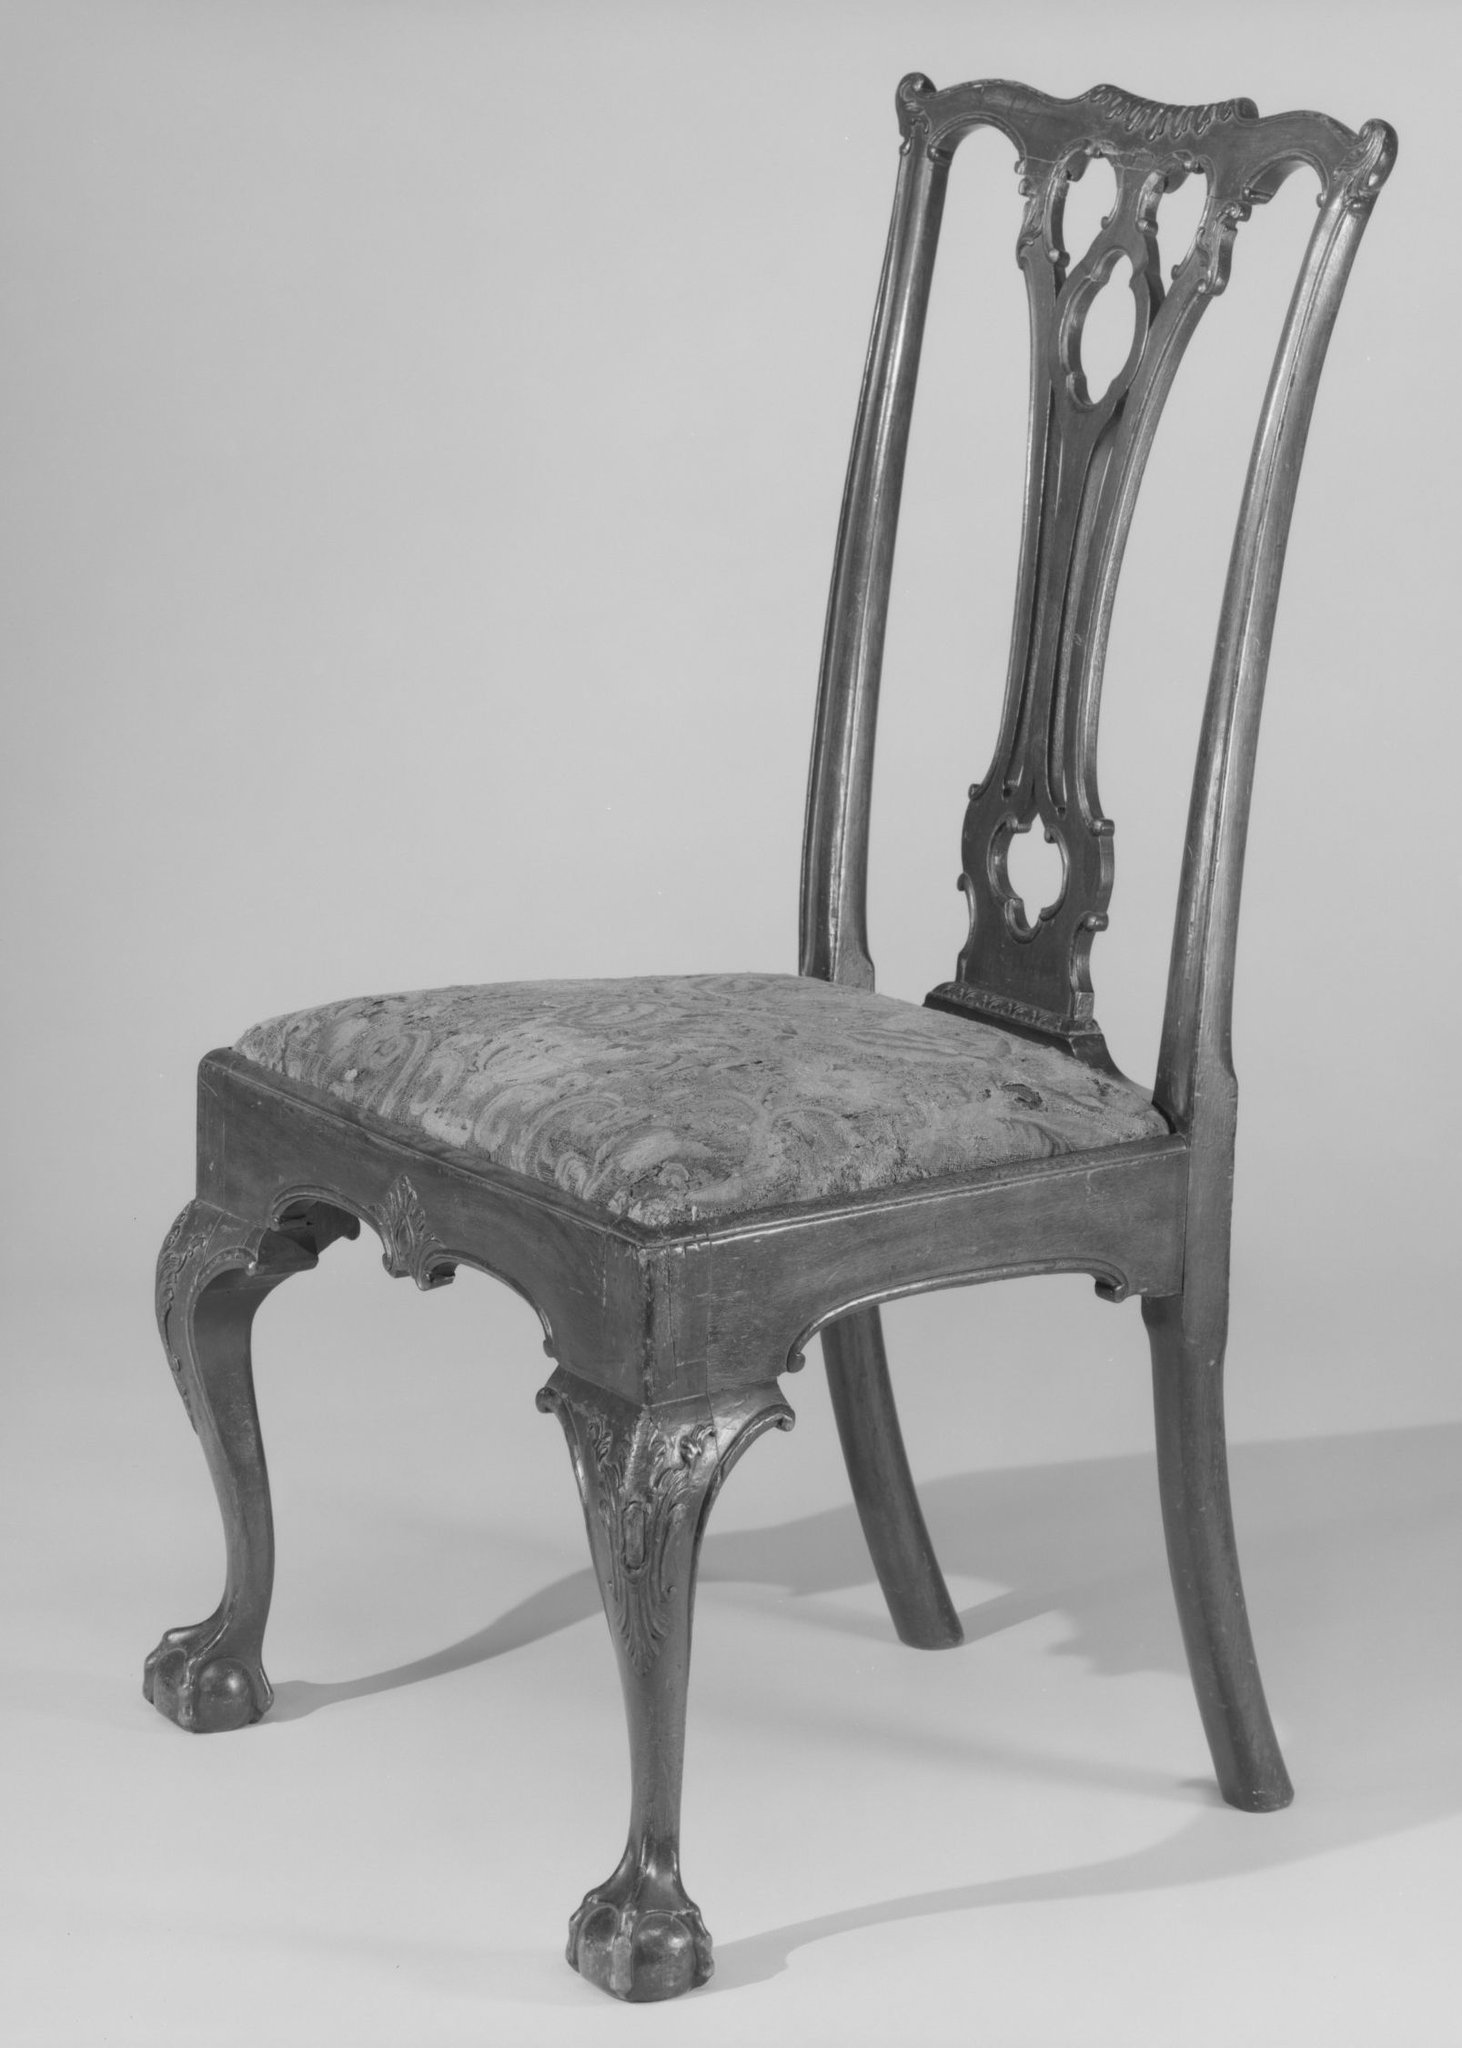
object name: side chair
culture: american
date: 1760-1790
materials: wood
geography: united states